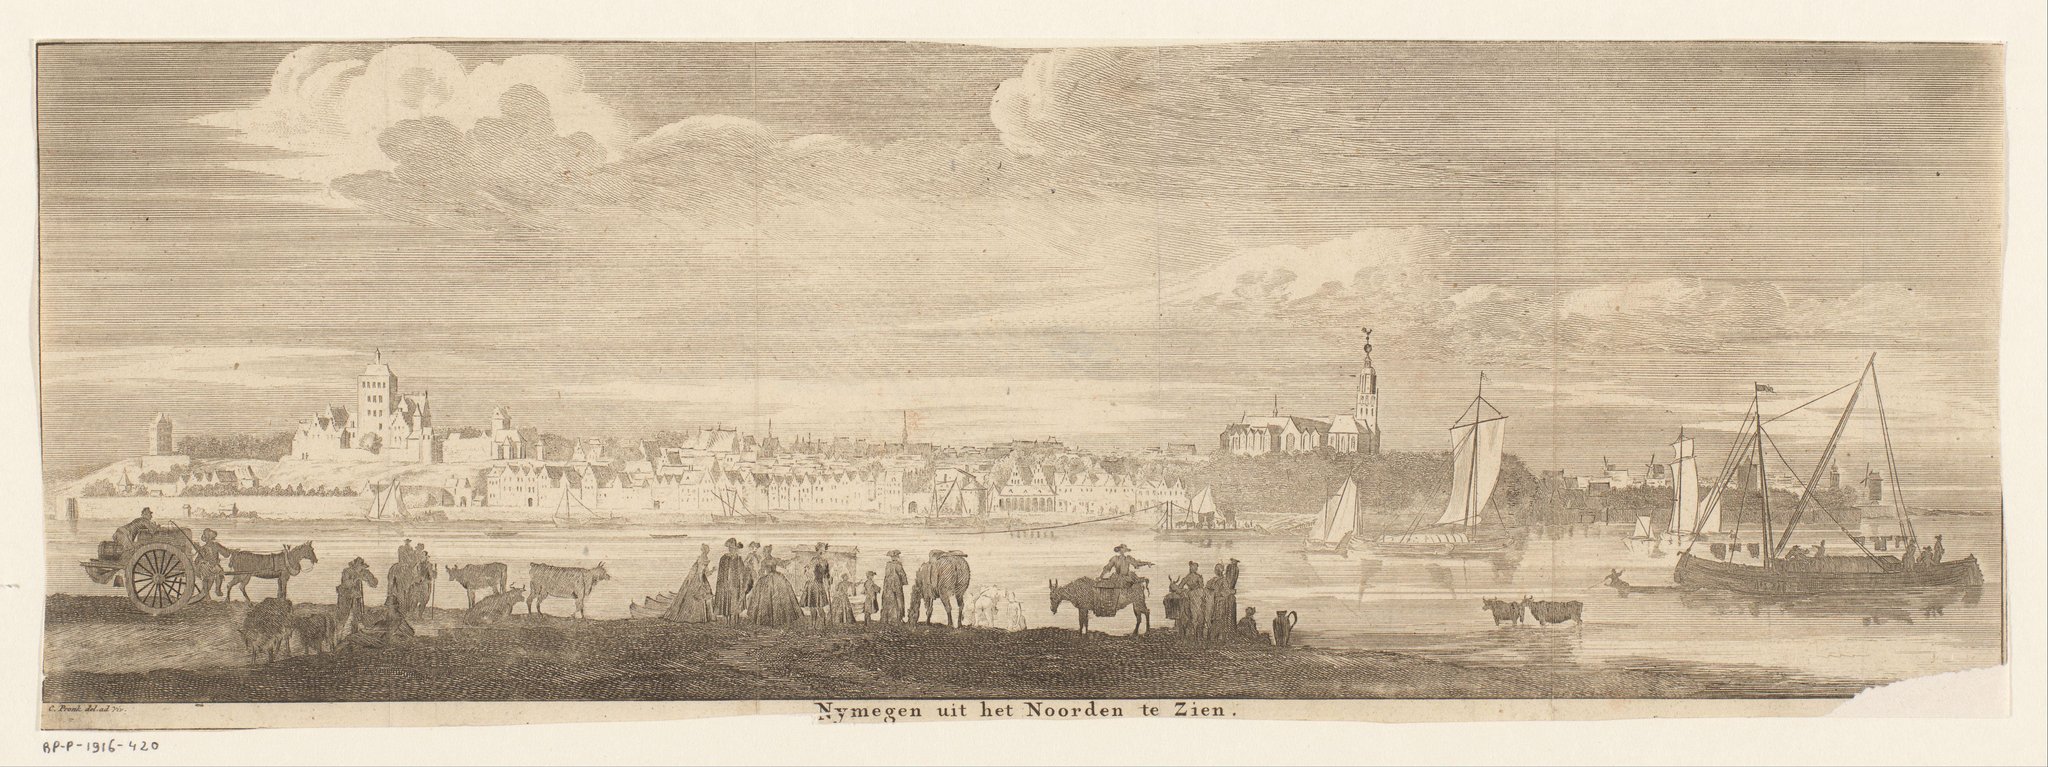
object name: print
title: Gezicht op Nijmegen vanuit het noorden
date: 1726-1744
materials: paper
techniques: etching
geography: amsterdam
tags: cow, sailing-ship, sailing-boat, prospect of city, town panorama, silhouette of city, nijmegen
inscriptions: collector's mark: Lugt 2228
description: Gezicht over de rivier de Waal op de stad Nijmegen, met rechts de Sint-Stevenskerk en links het Valkhof. Op de voorgrond enkele koeien en diverse figuren.